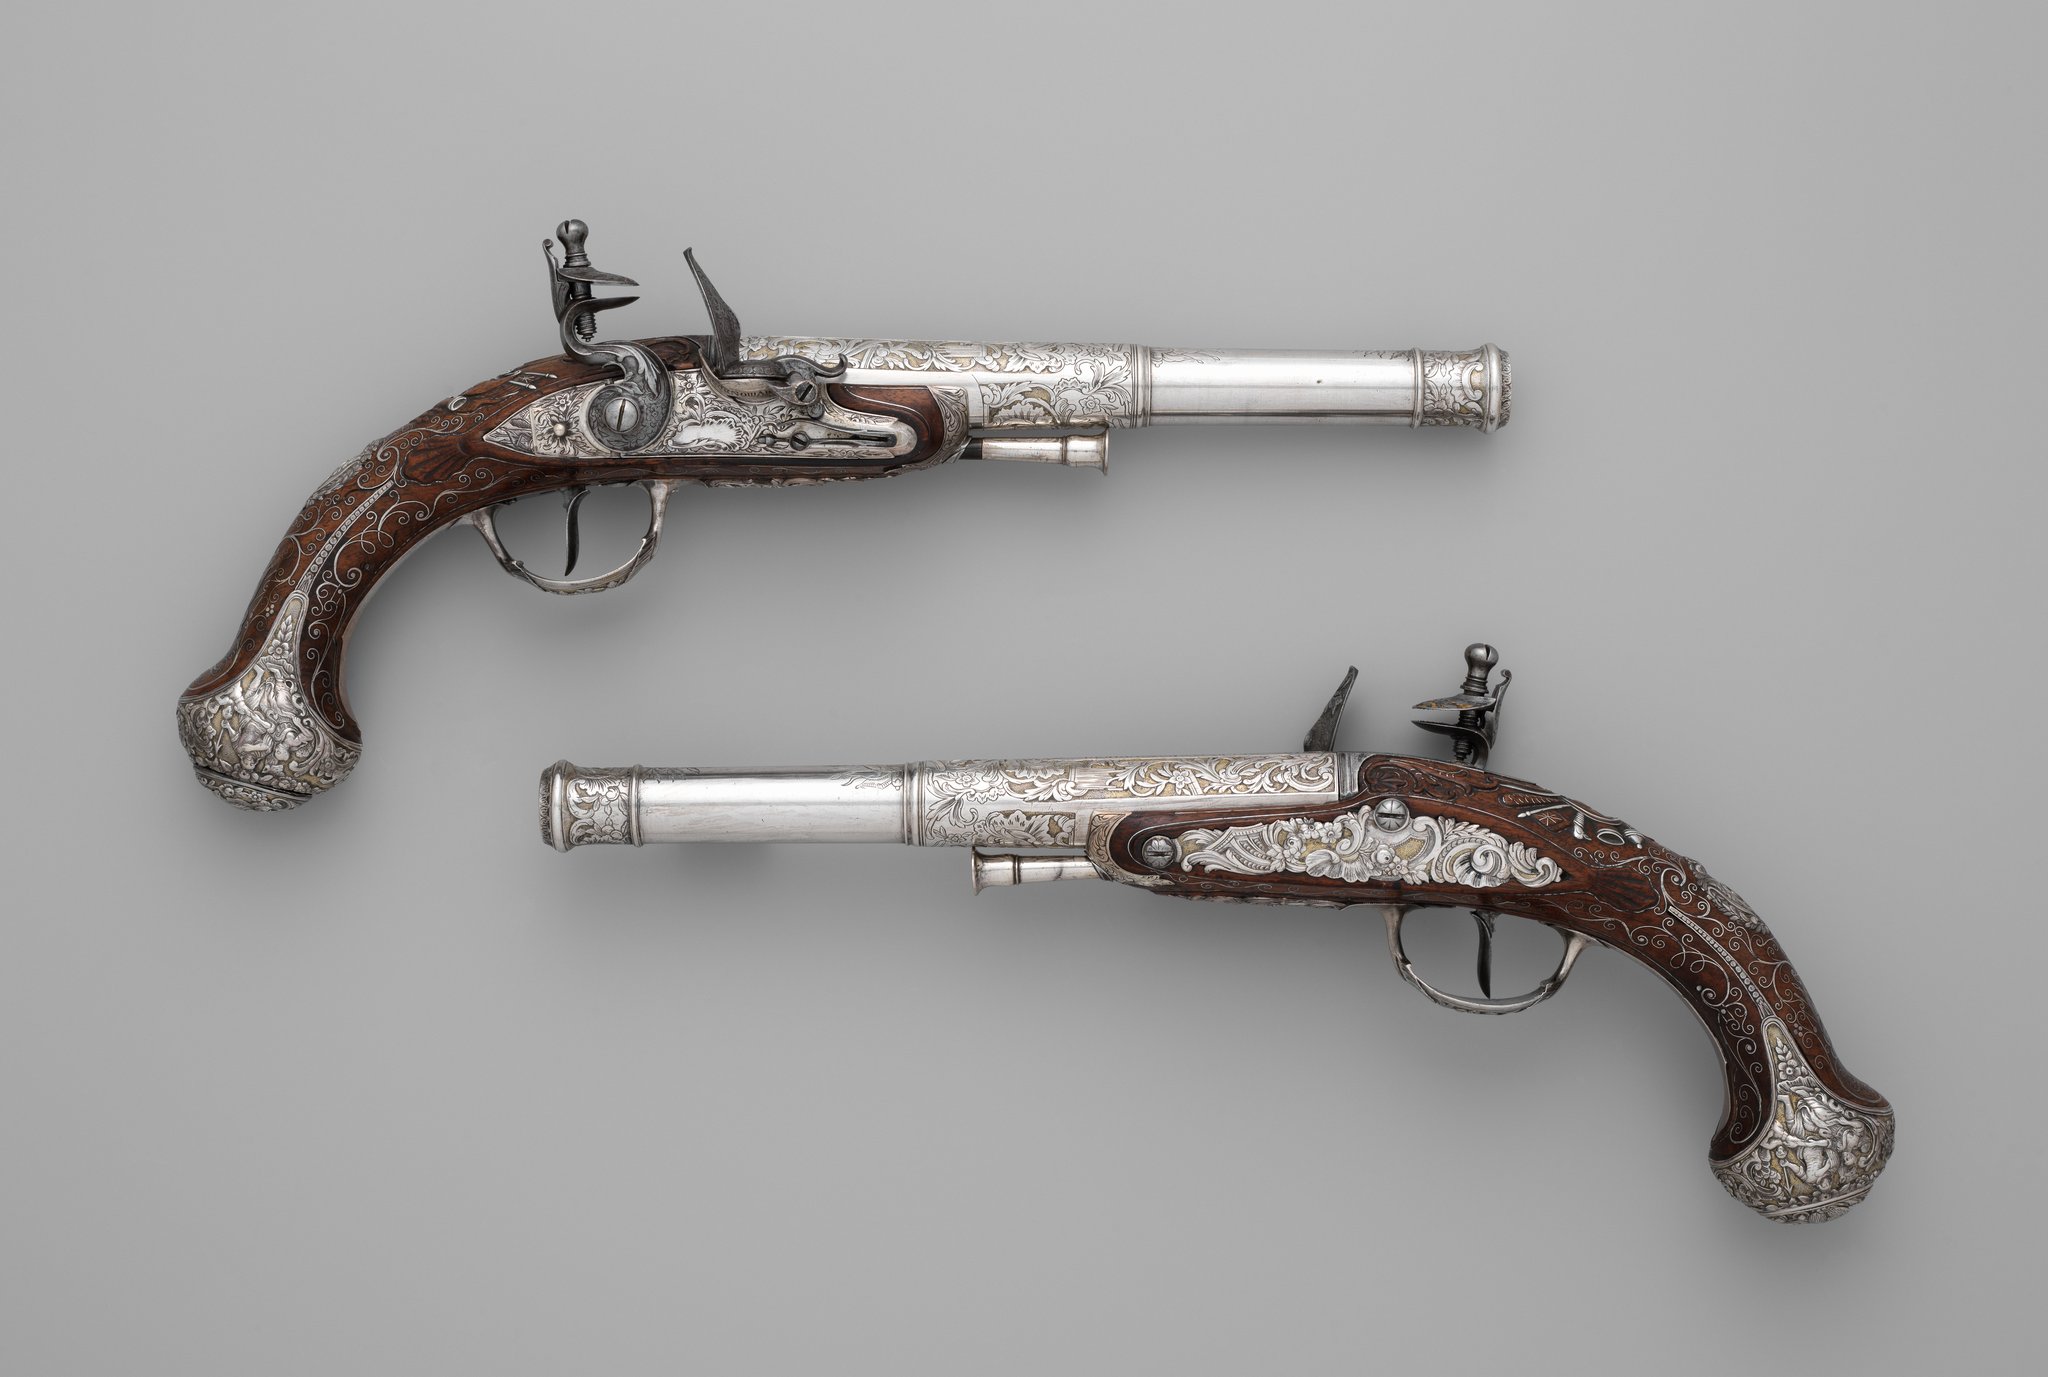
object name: pair of flintlock pistol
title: Pair of Flintlock Pistols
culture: indian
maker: claude martin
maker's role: patron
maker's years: 1735-1800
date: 1786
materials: gold, silver, steel, wood